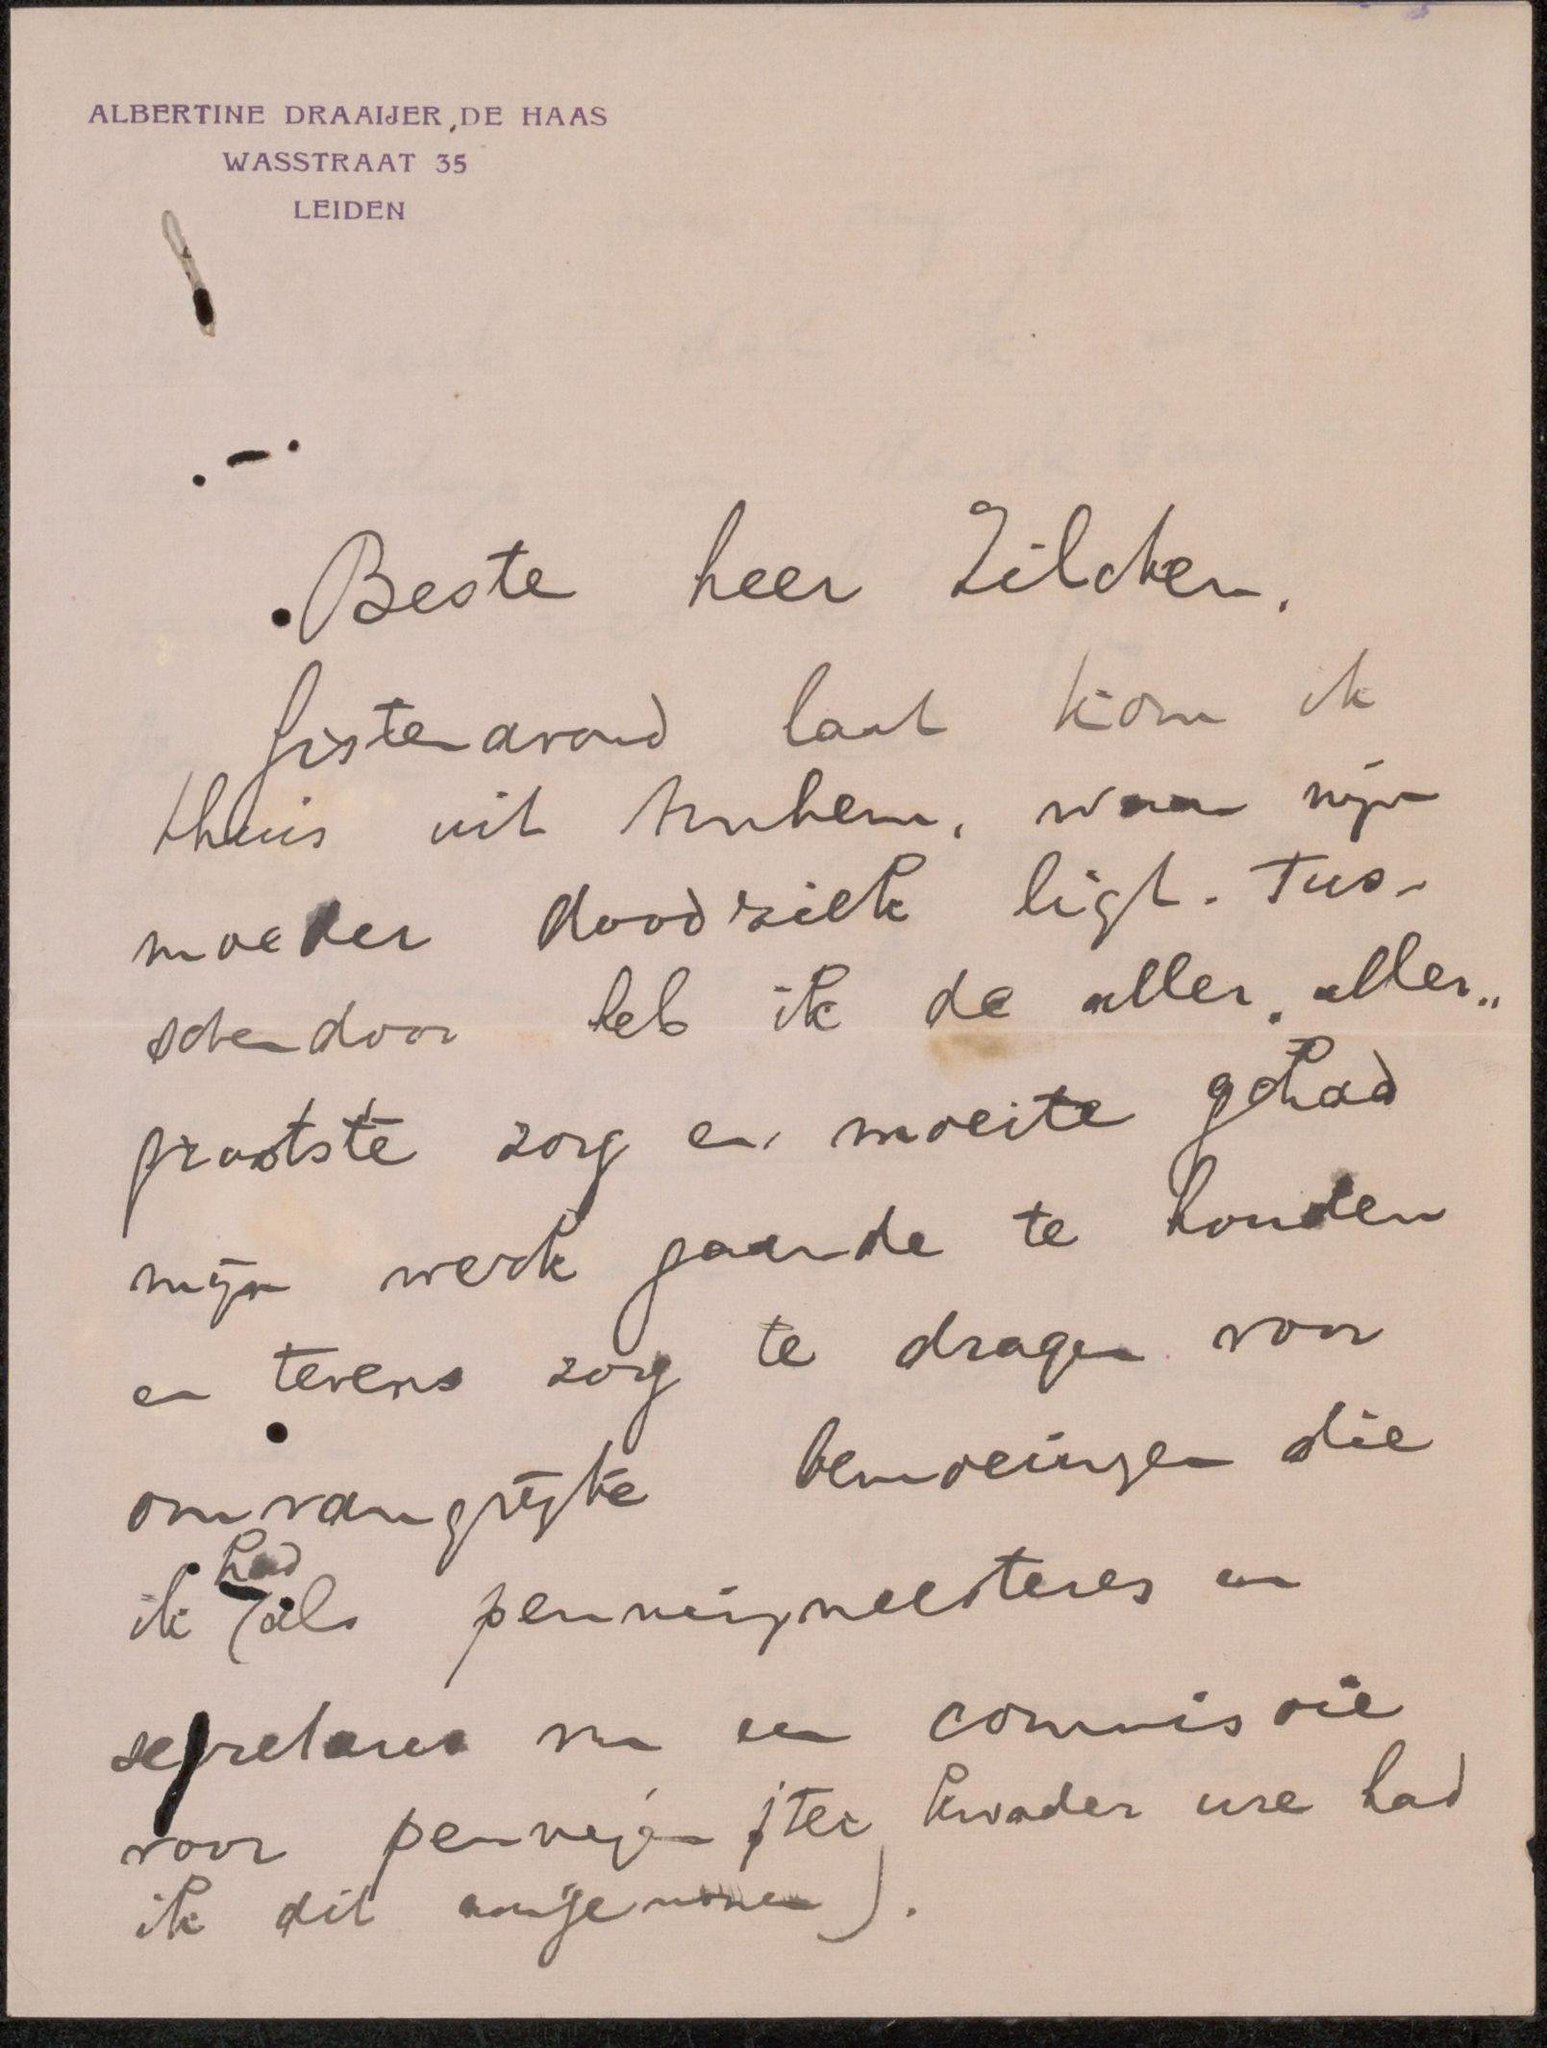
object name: letter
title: Brief aan Philip Zilcken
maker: albertine draaijer-de haas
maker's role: kunstcriticus, schrijver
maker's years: 1875-1952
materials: ink, paper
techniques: pen, printing, writing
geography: leiden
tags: the hague, painter, draughtsman, philip zilcken, family life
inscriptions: address: ‘RPK’, collector's mark: ‘RPK’